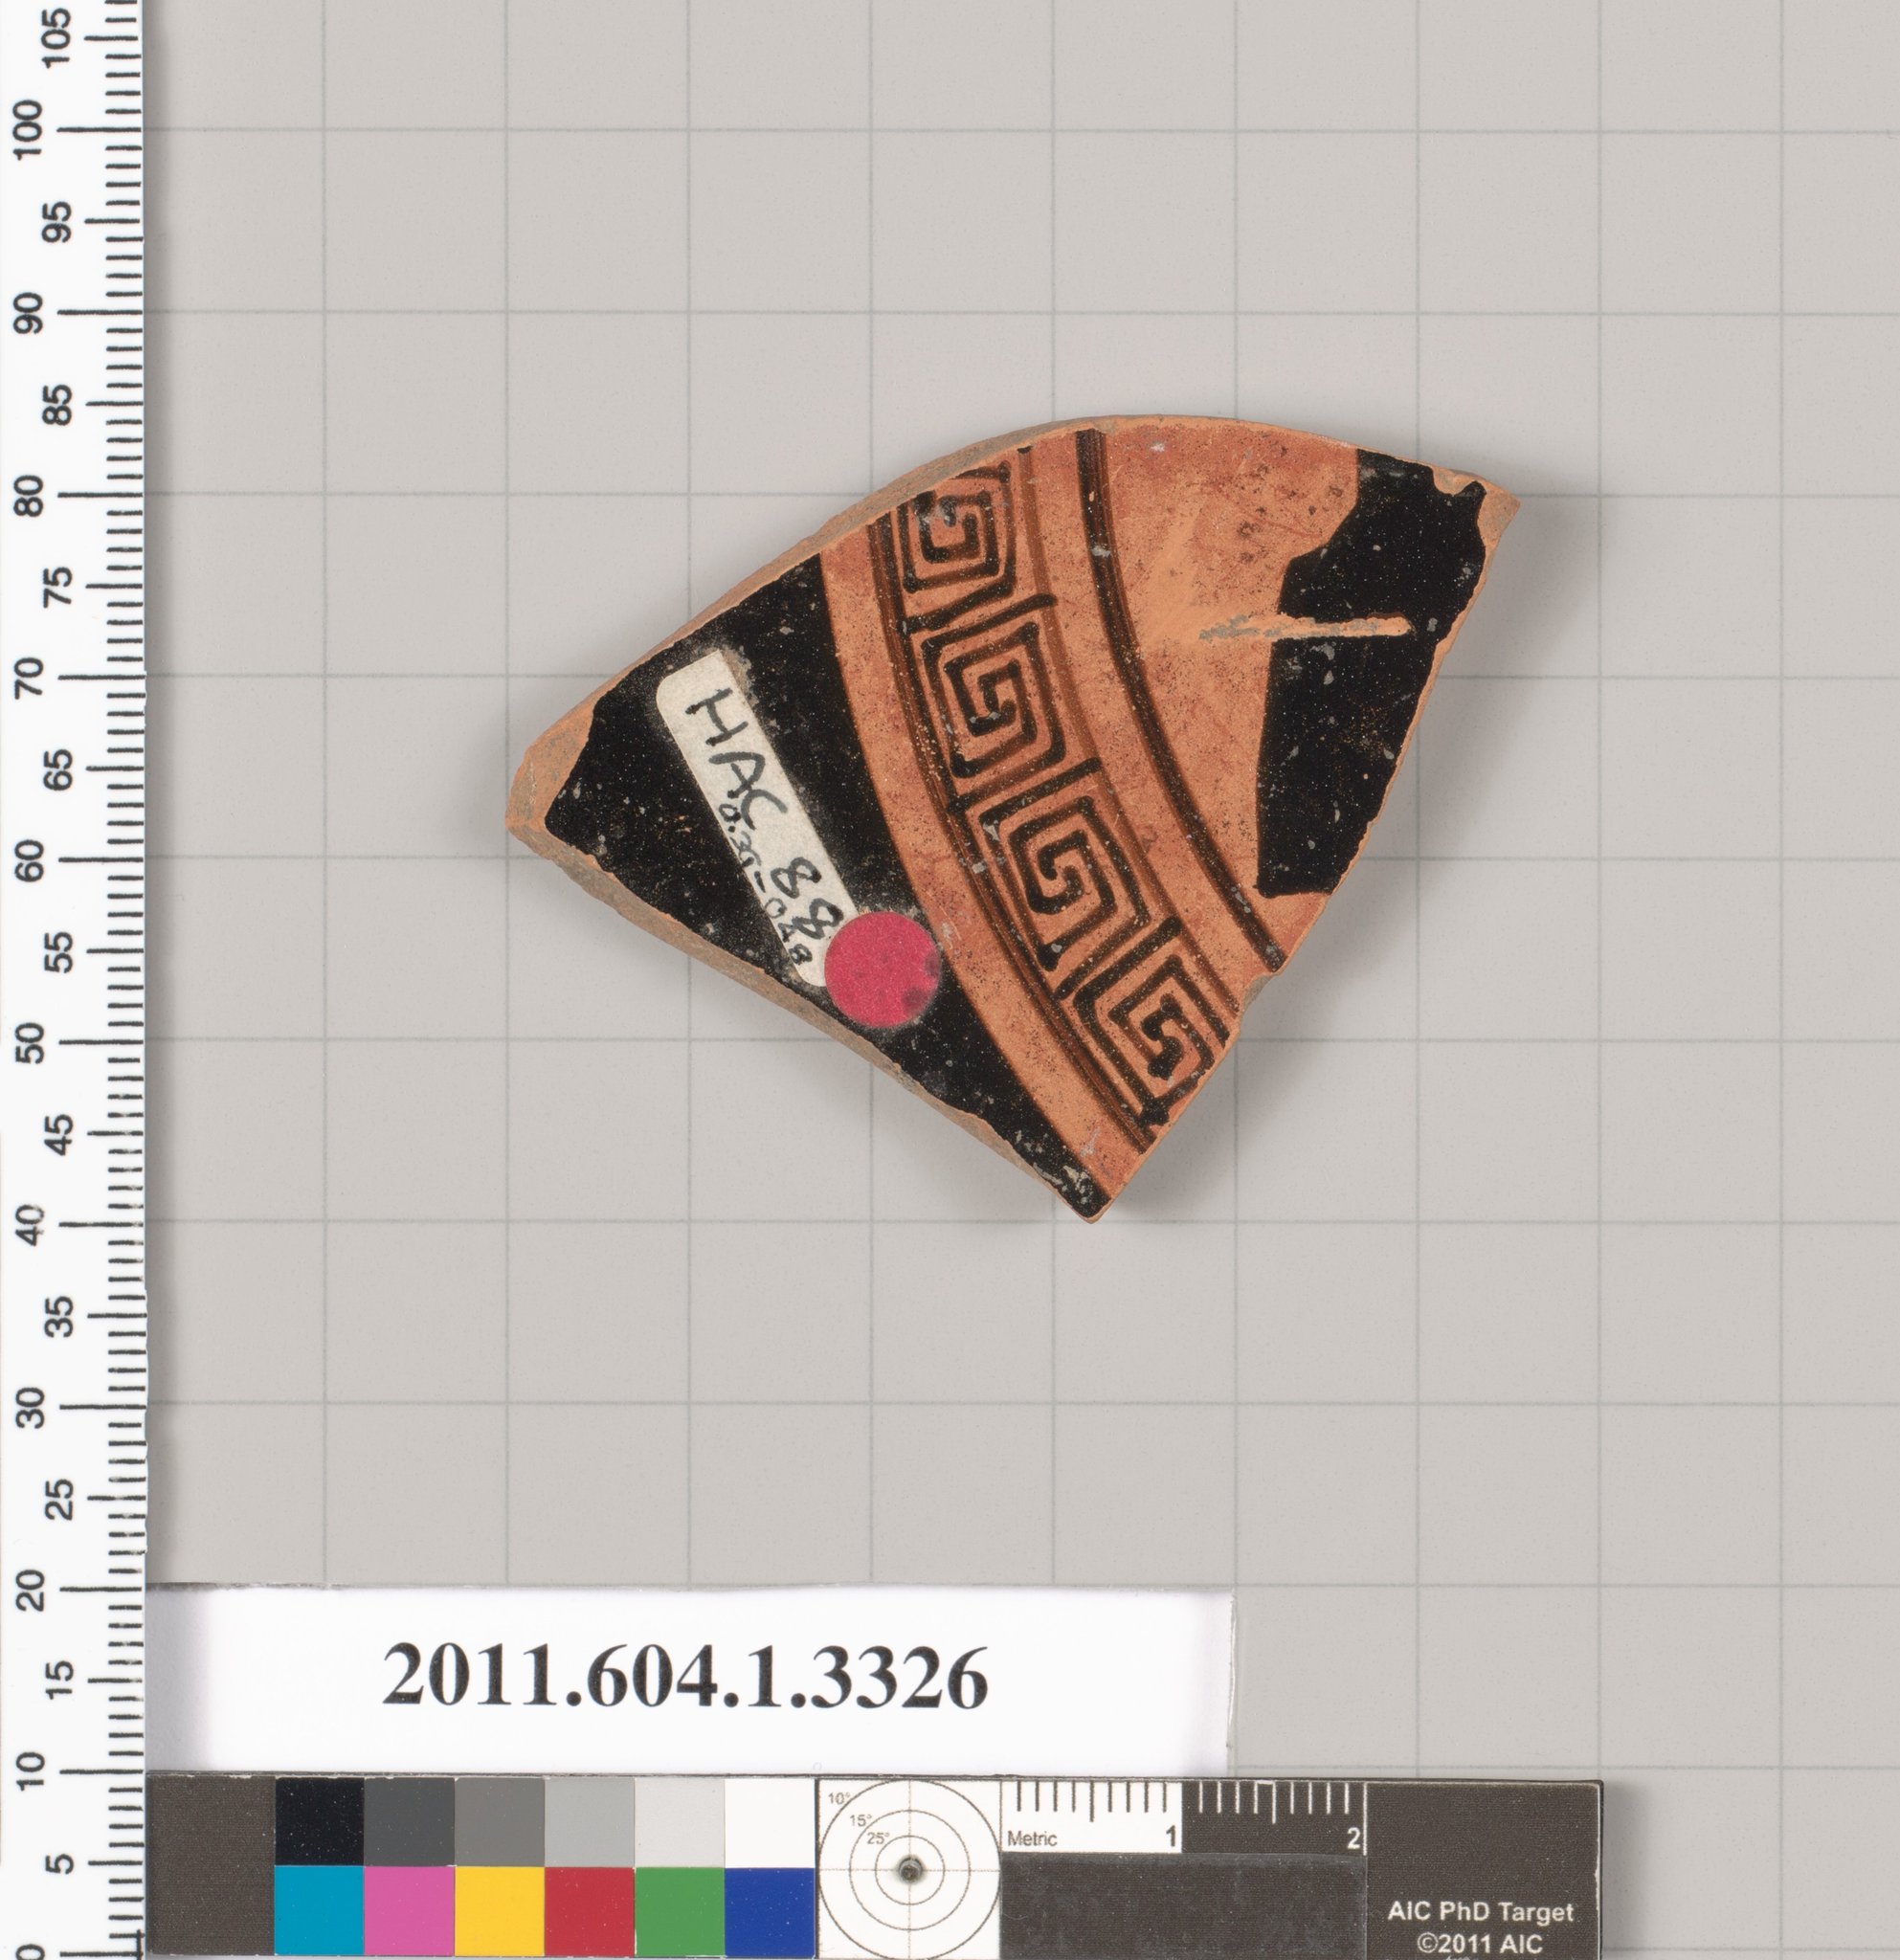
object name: kylix fragment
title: Terracotta fragment of a kylix (drinking cup)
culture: greek, attic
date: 475-451 BCE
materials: terracotta